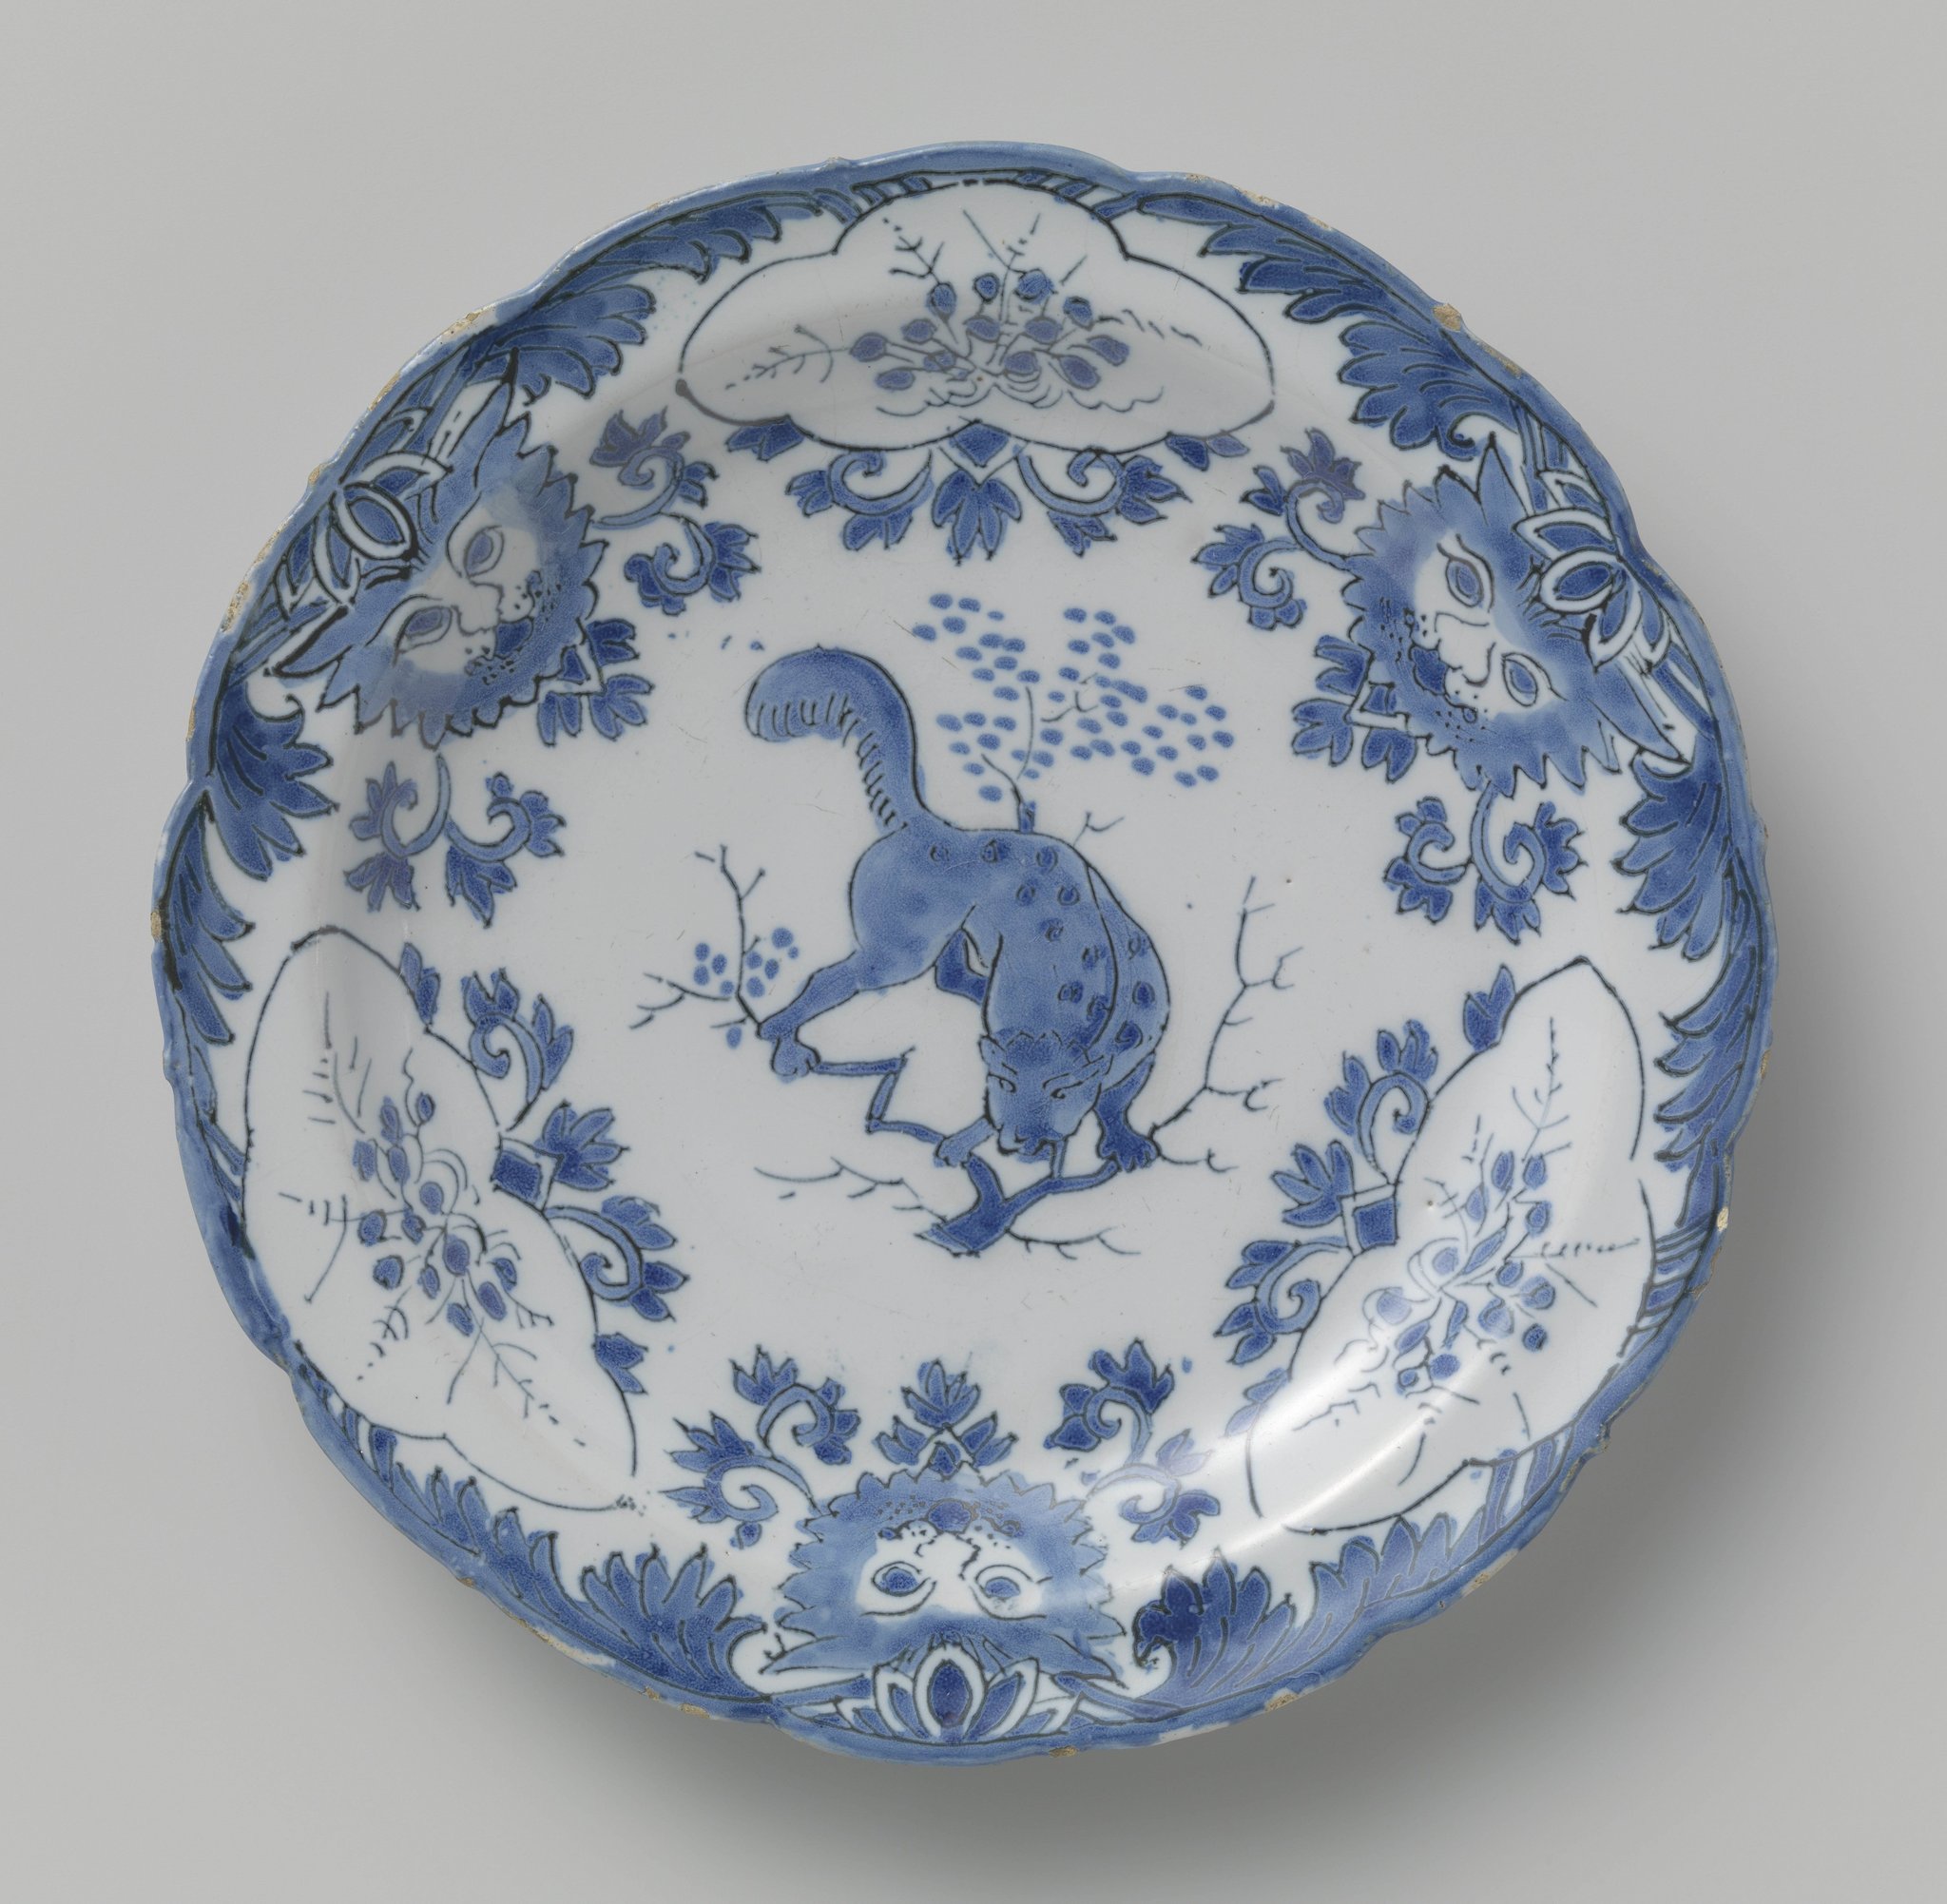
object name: plate dish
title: Dish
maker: adrianus kocx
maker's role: plateelbakker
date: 1685-1695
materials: earthenware, glaze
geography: delft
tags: beasts of prey, predatory animals: leopard, ornament derived from plant forms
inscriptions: mark: ‘AK’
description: bordje van aardewerk met een chinoiserie decoratie, gedeeltelijk naar voorbeeld van het Japanse kakiemon porselein